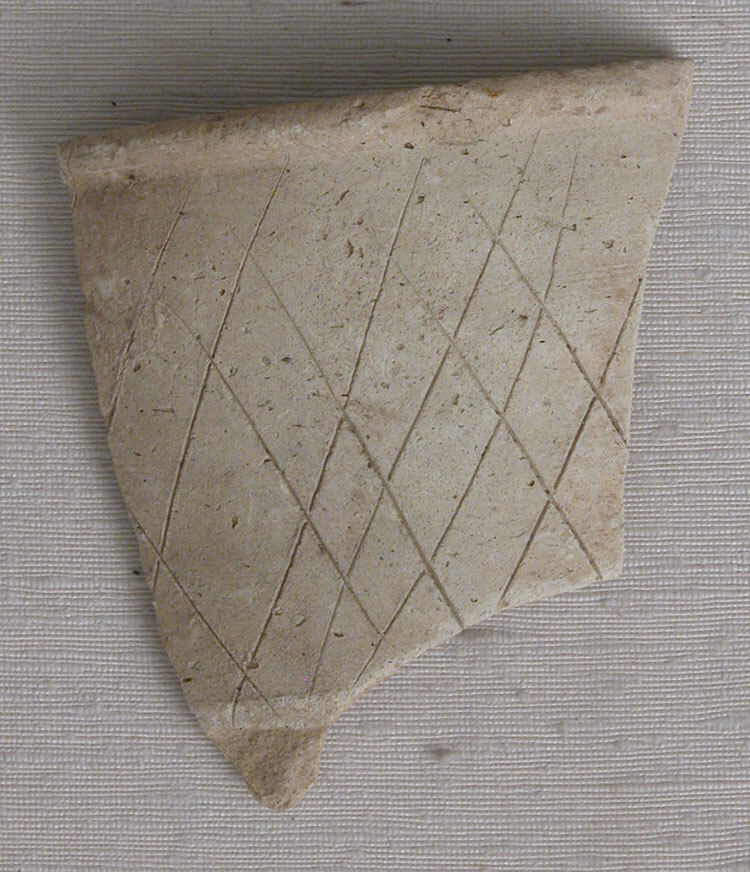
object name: fragment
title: Ceramic Fragment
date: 701-900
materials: earthenware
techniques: incising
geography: iraq